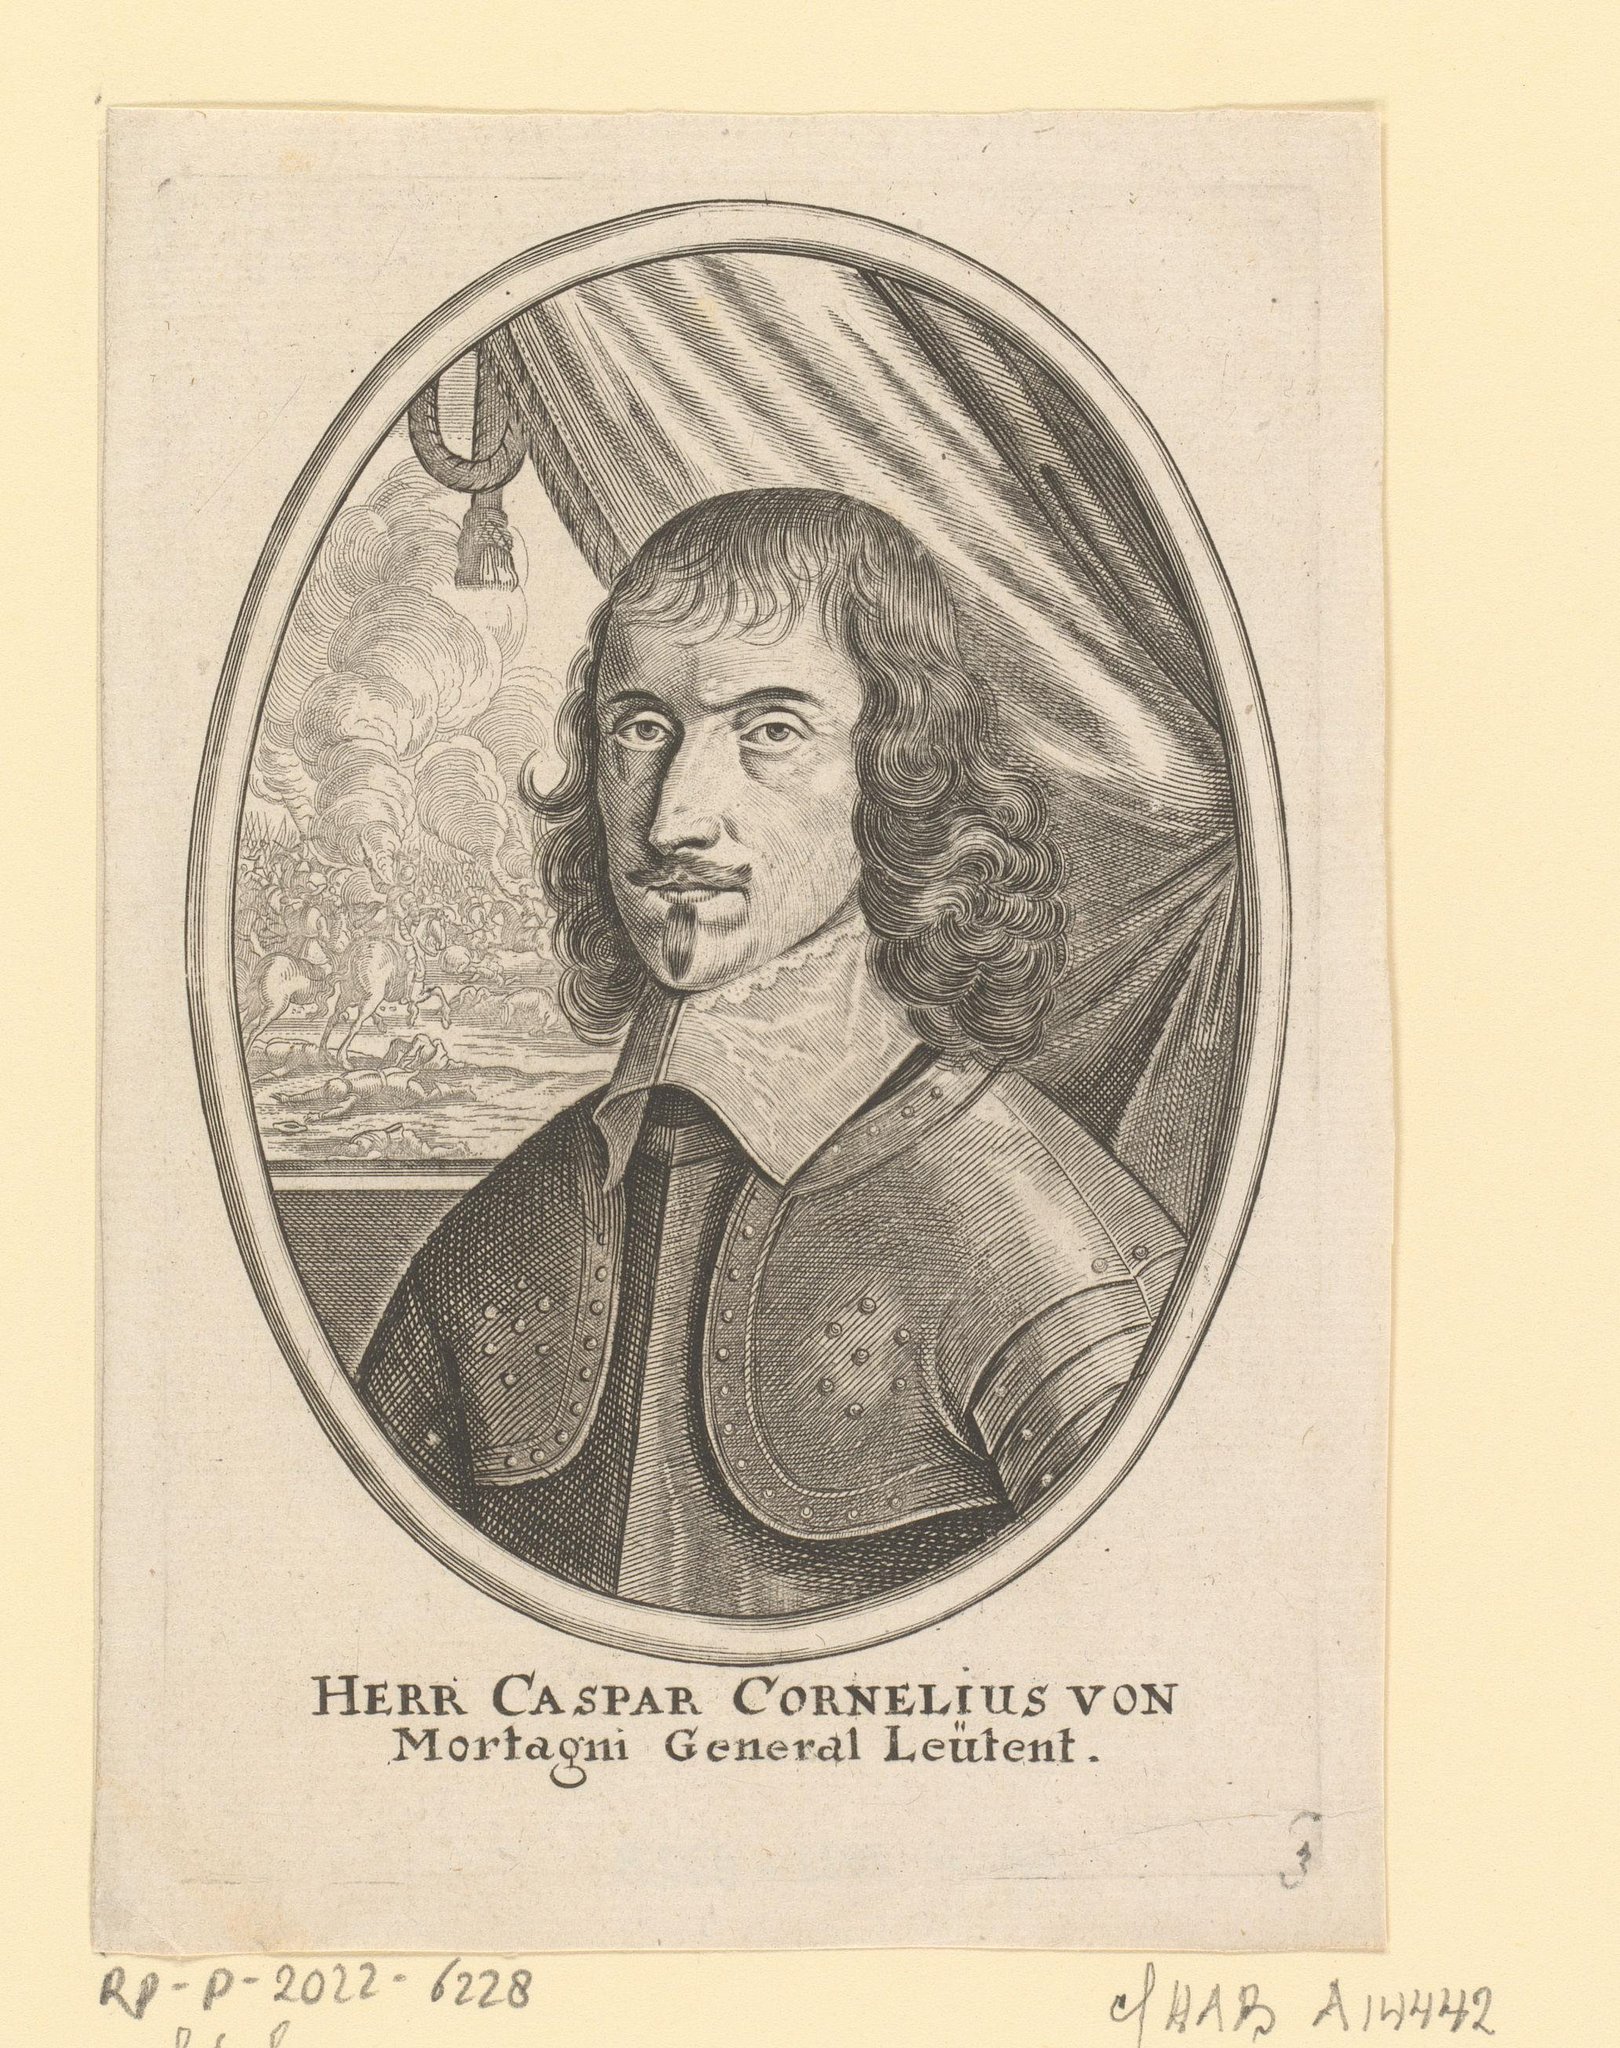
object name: print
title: Portret van Kaspar Kornelius Mortaigne de Potelles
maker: Anonymous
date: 1646-1686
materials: paper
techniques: engraving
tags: commander-in-chief, general, marshal, historical persons